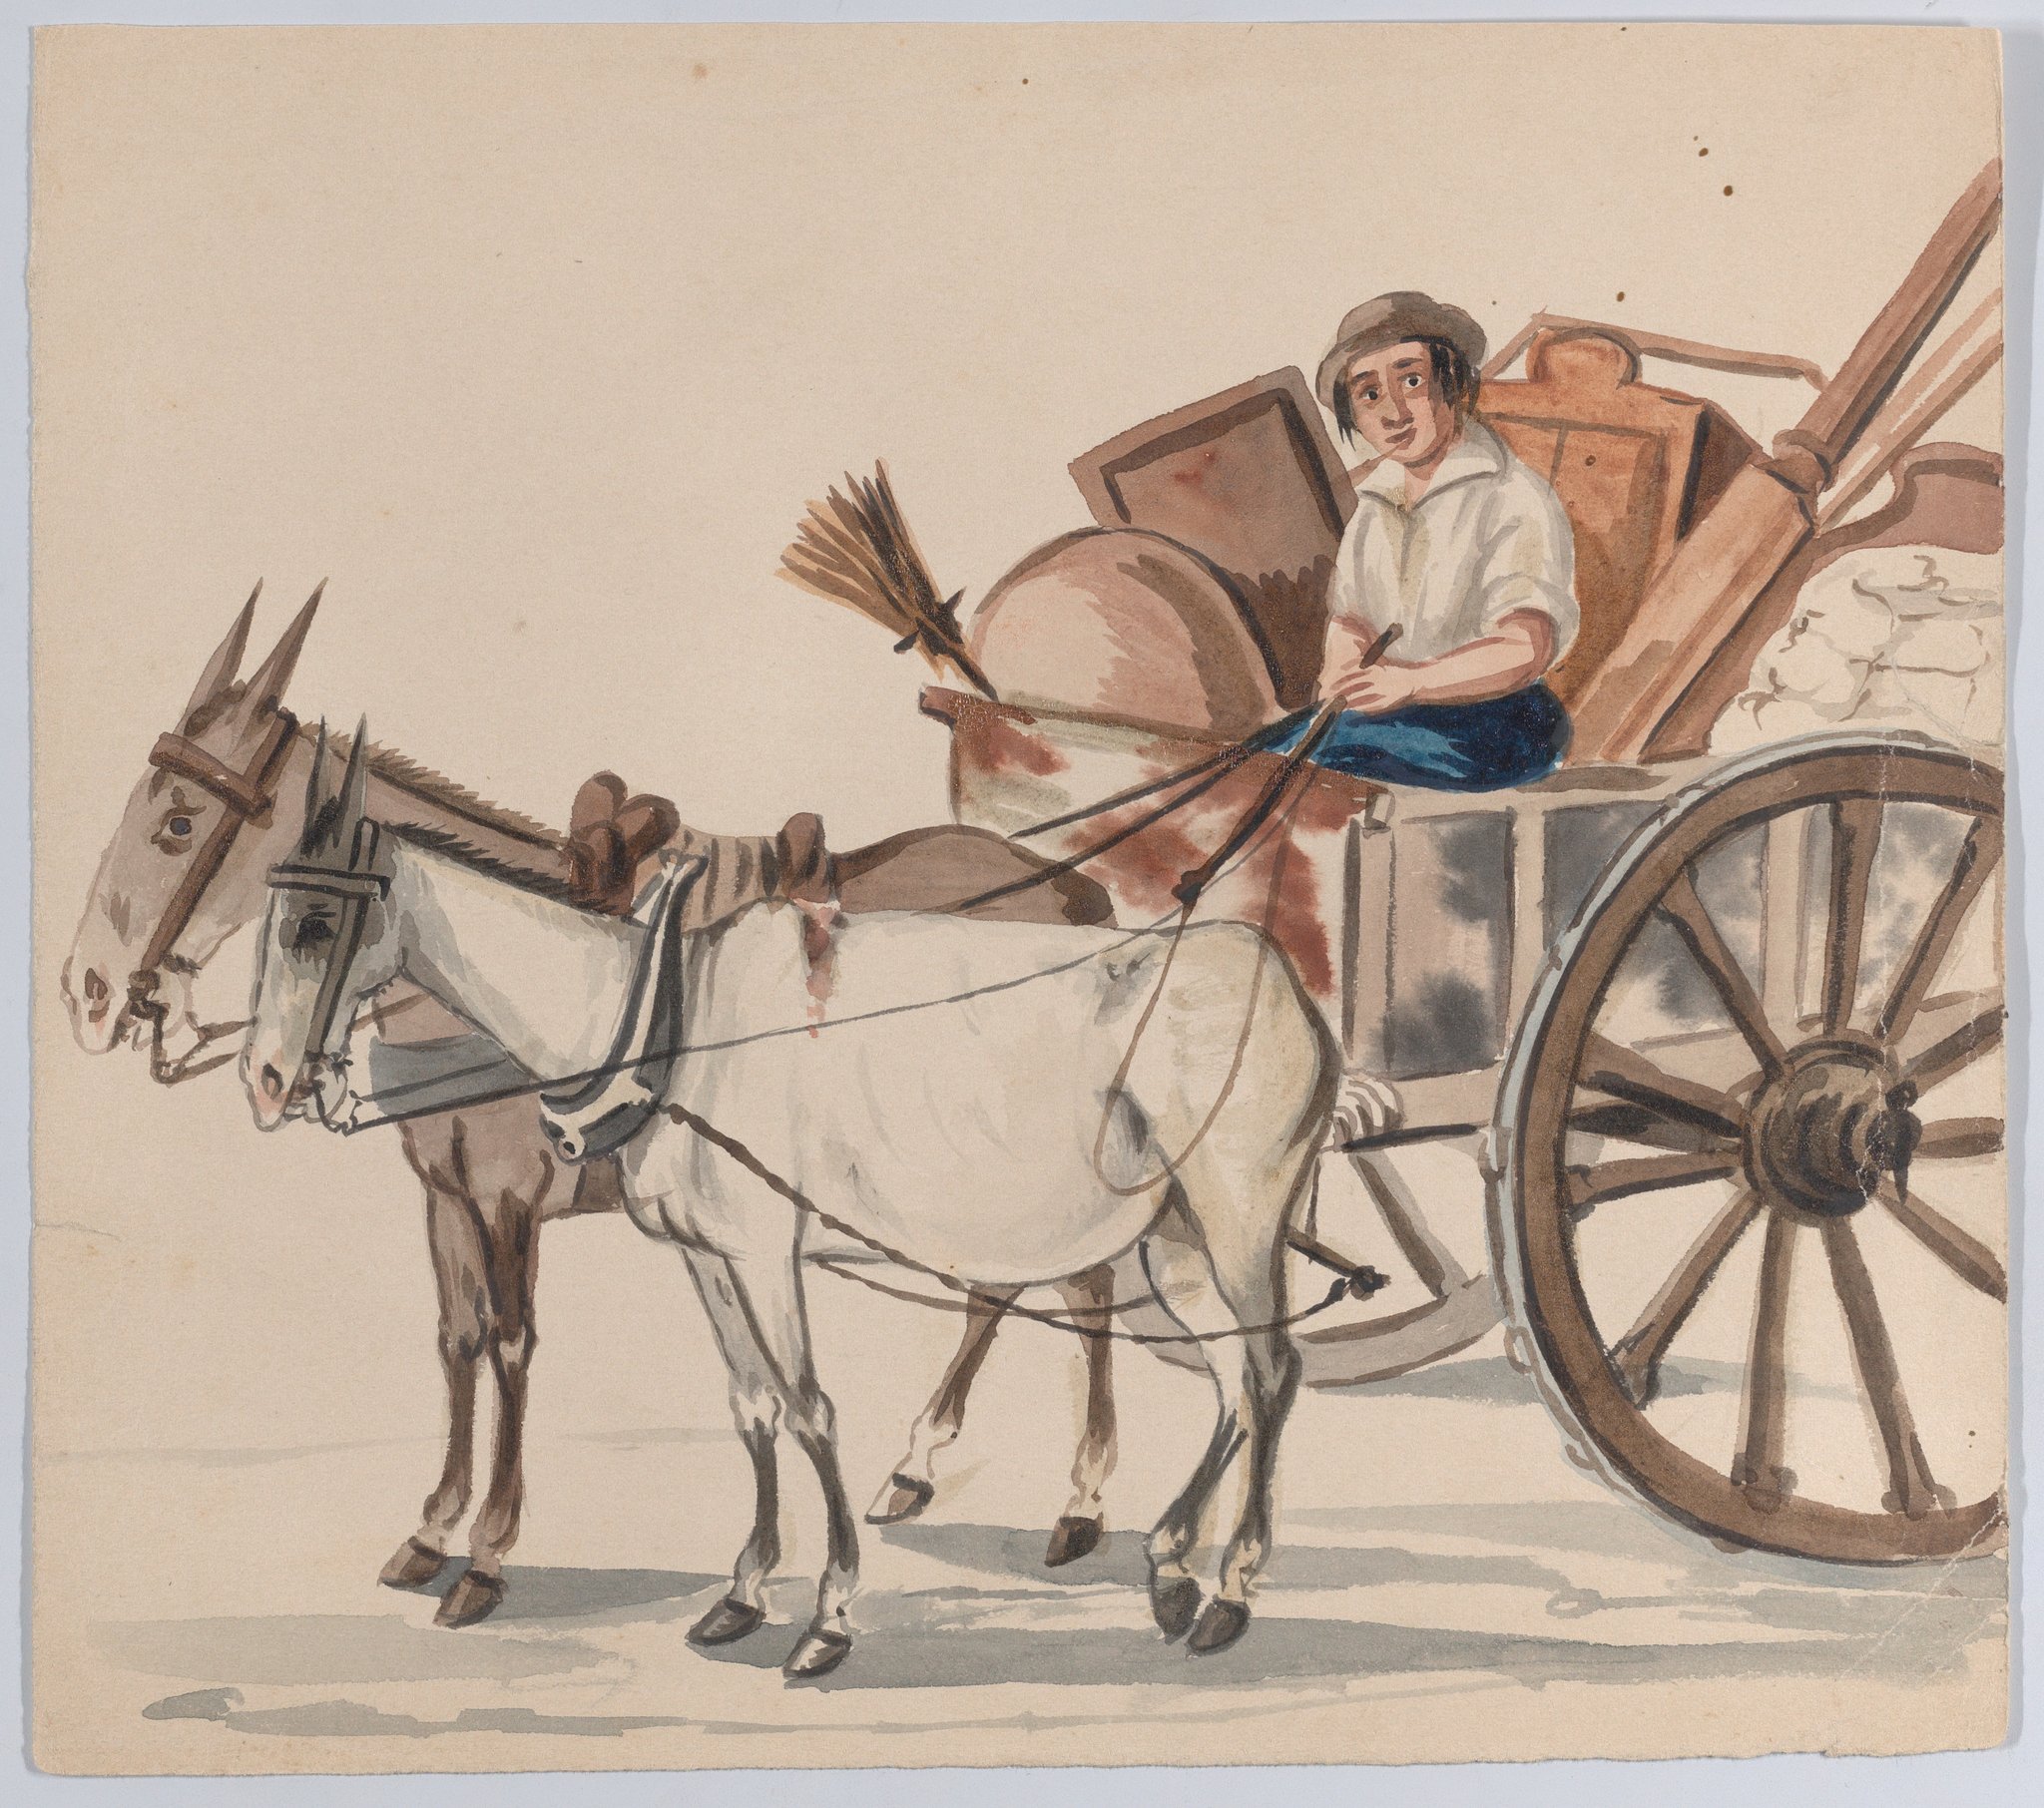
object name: drawing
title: A man driving a cart pulled by mules, from a group of drawings depicting Peruvian dress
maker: francisco (pancho) fierro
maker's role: artist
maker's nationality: african peruvian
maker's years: 1807-1879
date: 1848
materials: watercolor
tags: men,women